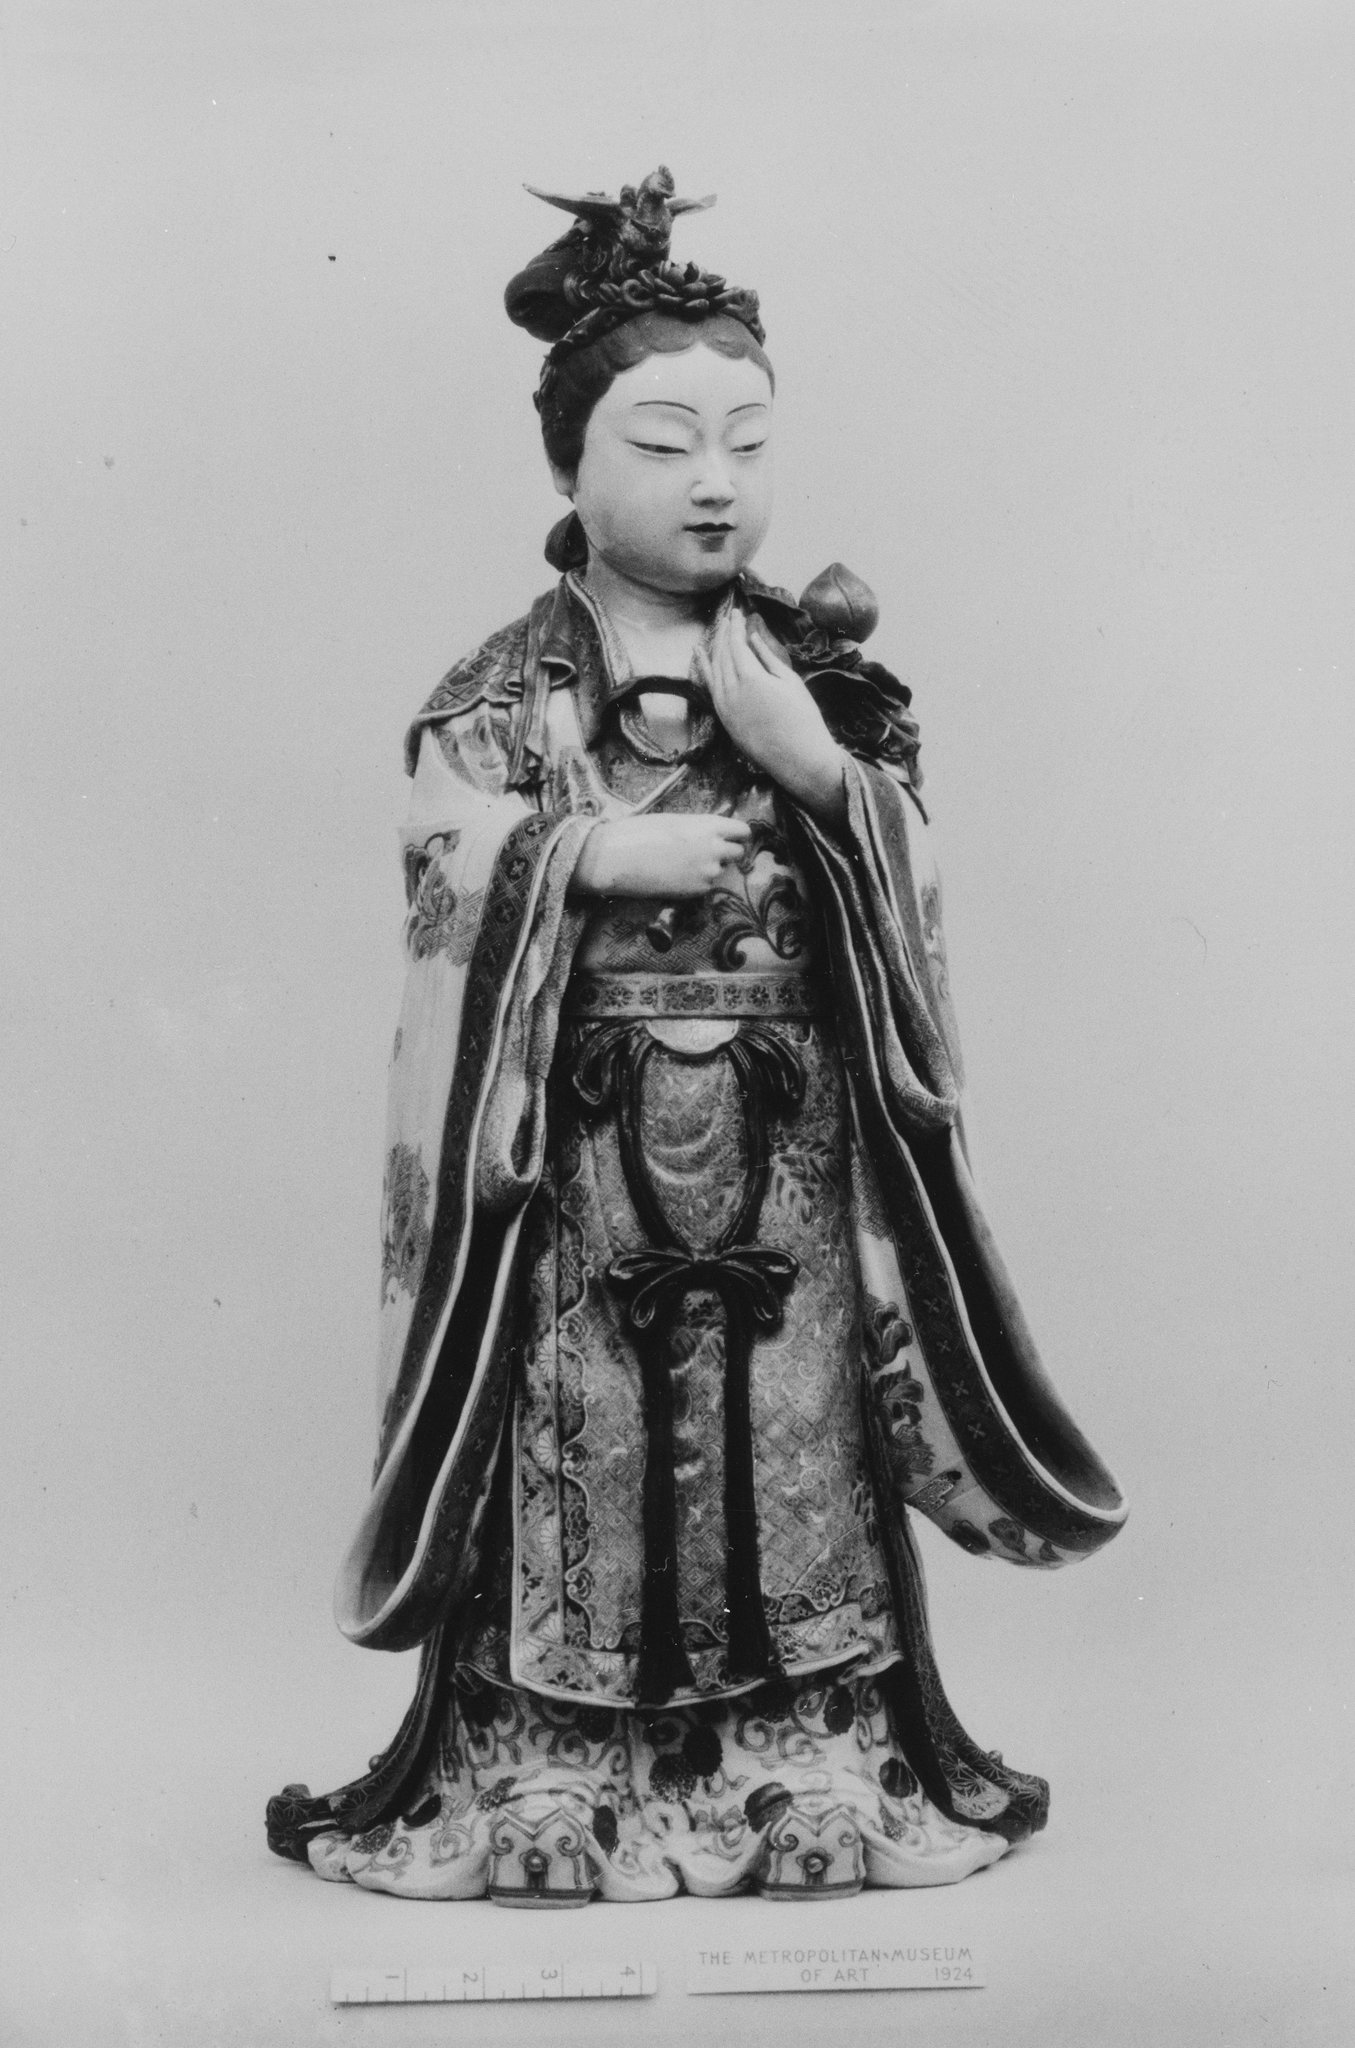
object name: figure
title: Goddess Benten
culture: japanese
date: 1867-1900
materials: enamel, faience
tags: goddess